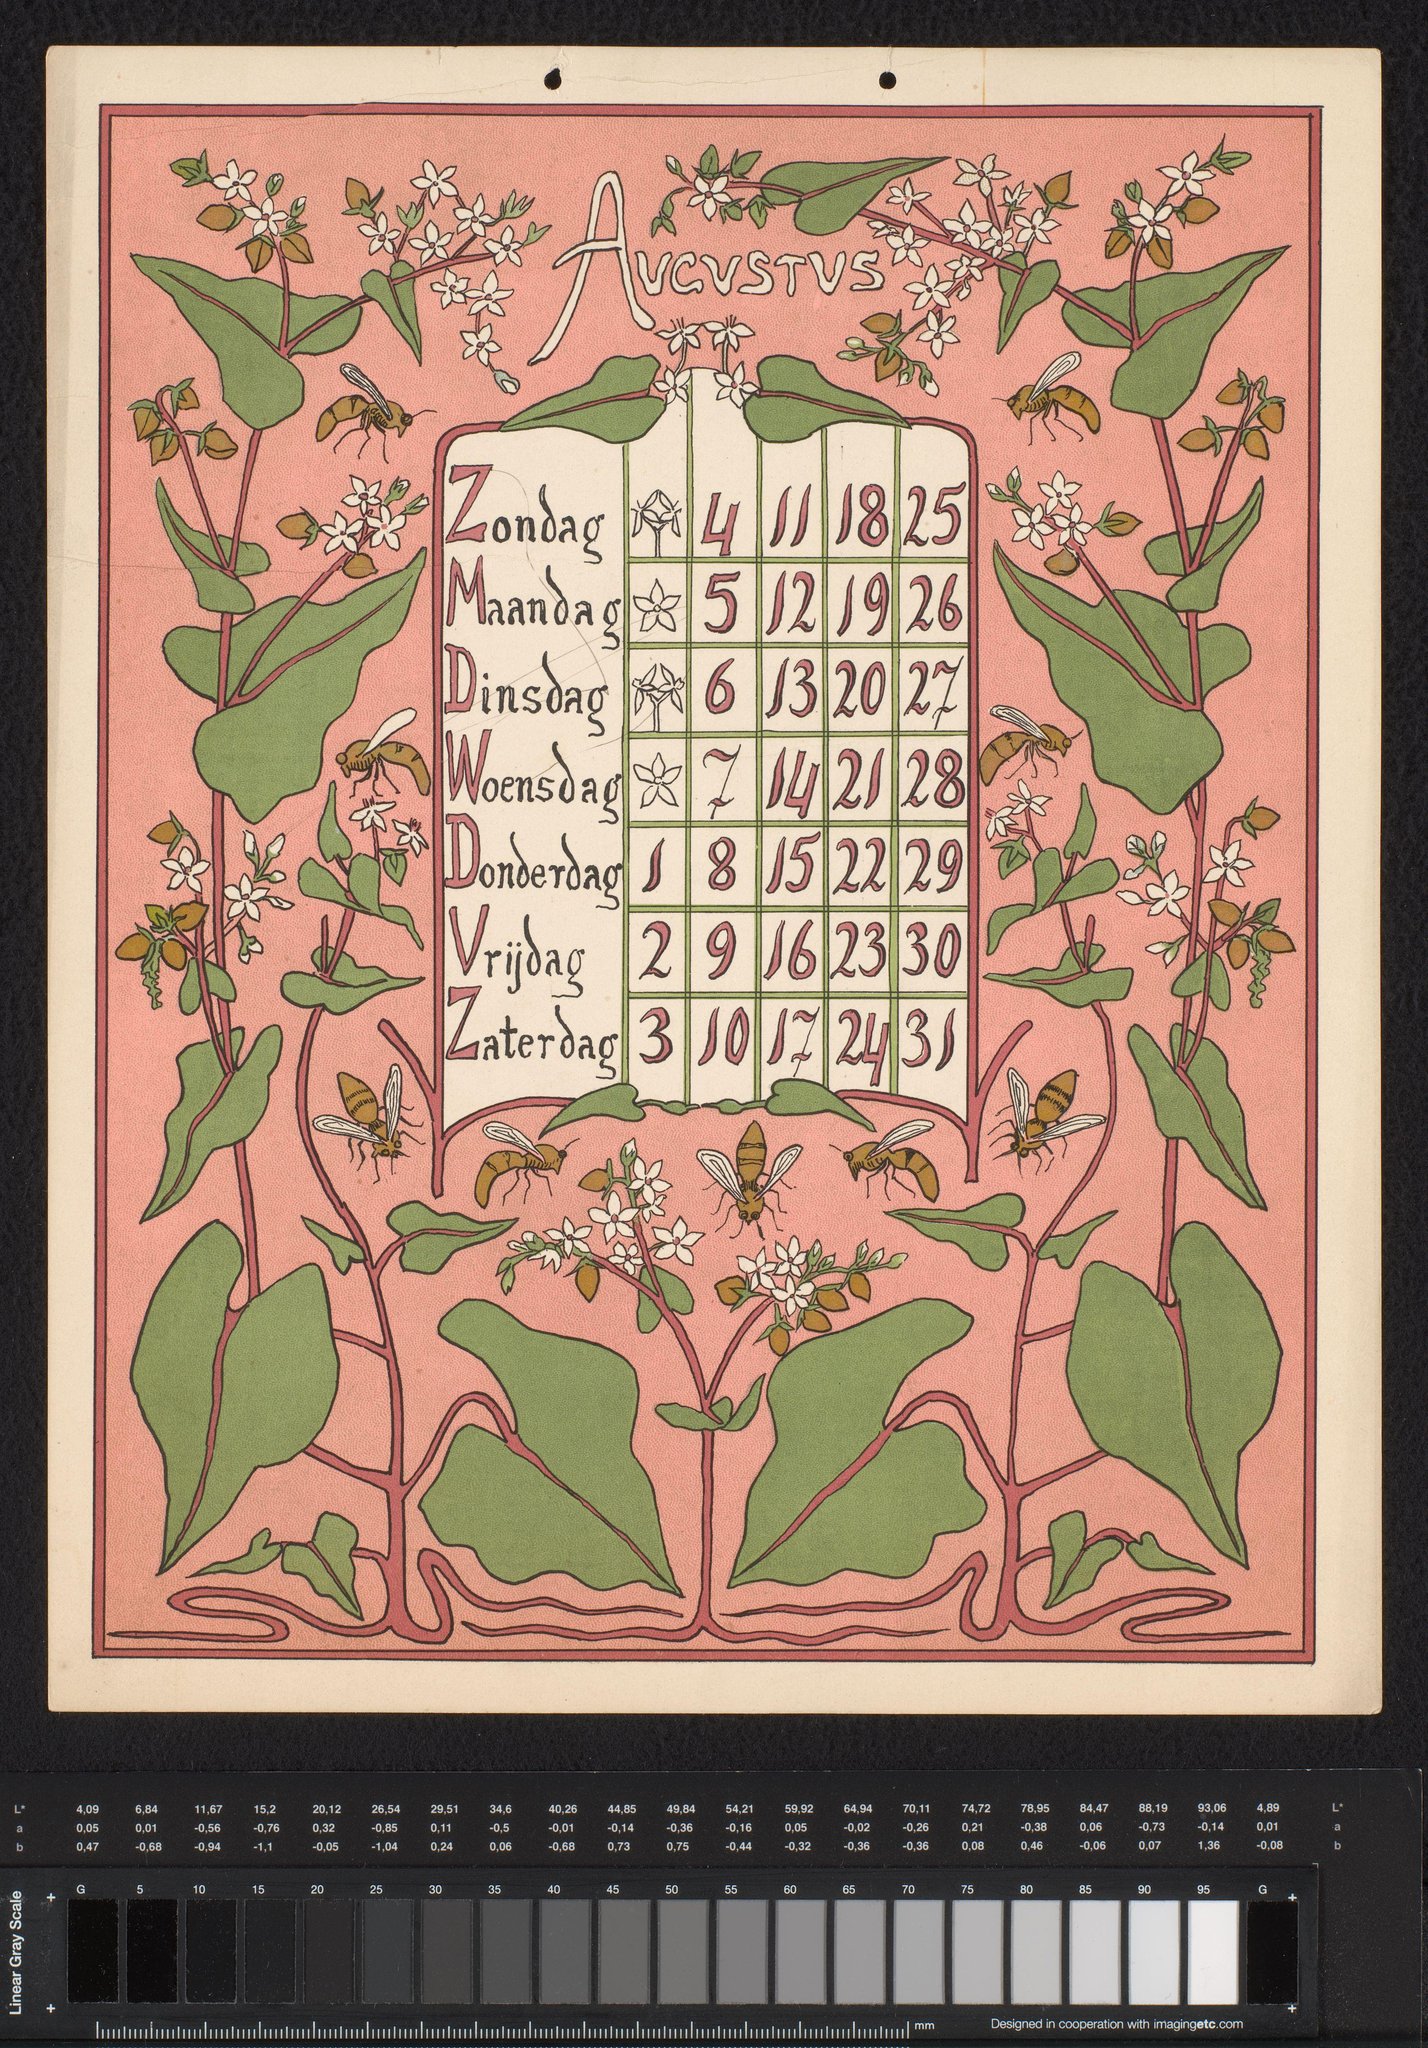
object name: print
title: Kalenderblad voor augustus 1901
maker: c.a.j. van dishoeck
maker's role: publisher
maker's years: 1863-1931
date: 1900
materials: paper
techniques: lithograph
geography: amsterdam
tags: flowers, ornaments ~ art, calendar, almanac, insects: bee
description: Kalenderblad voor augustus 1901 van de kalender 'Bloem en Blad', met een randdecoratie van bloemen en bijen.